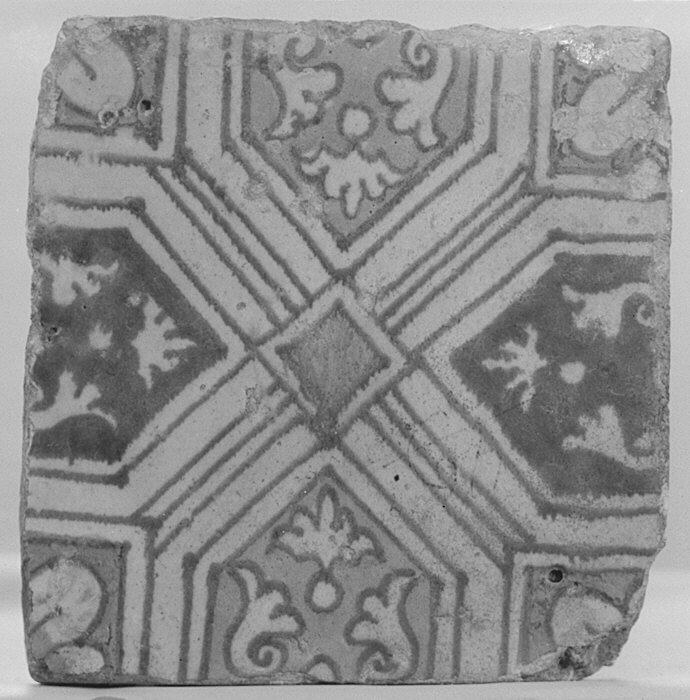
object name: floor tile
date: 1567-1600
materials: earthenware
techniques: glazing